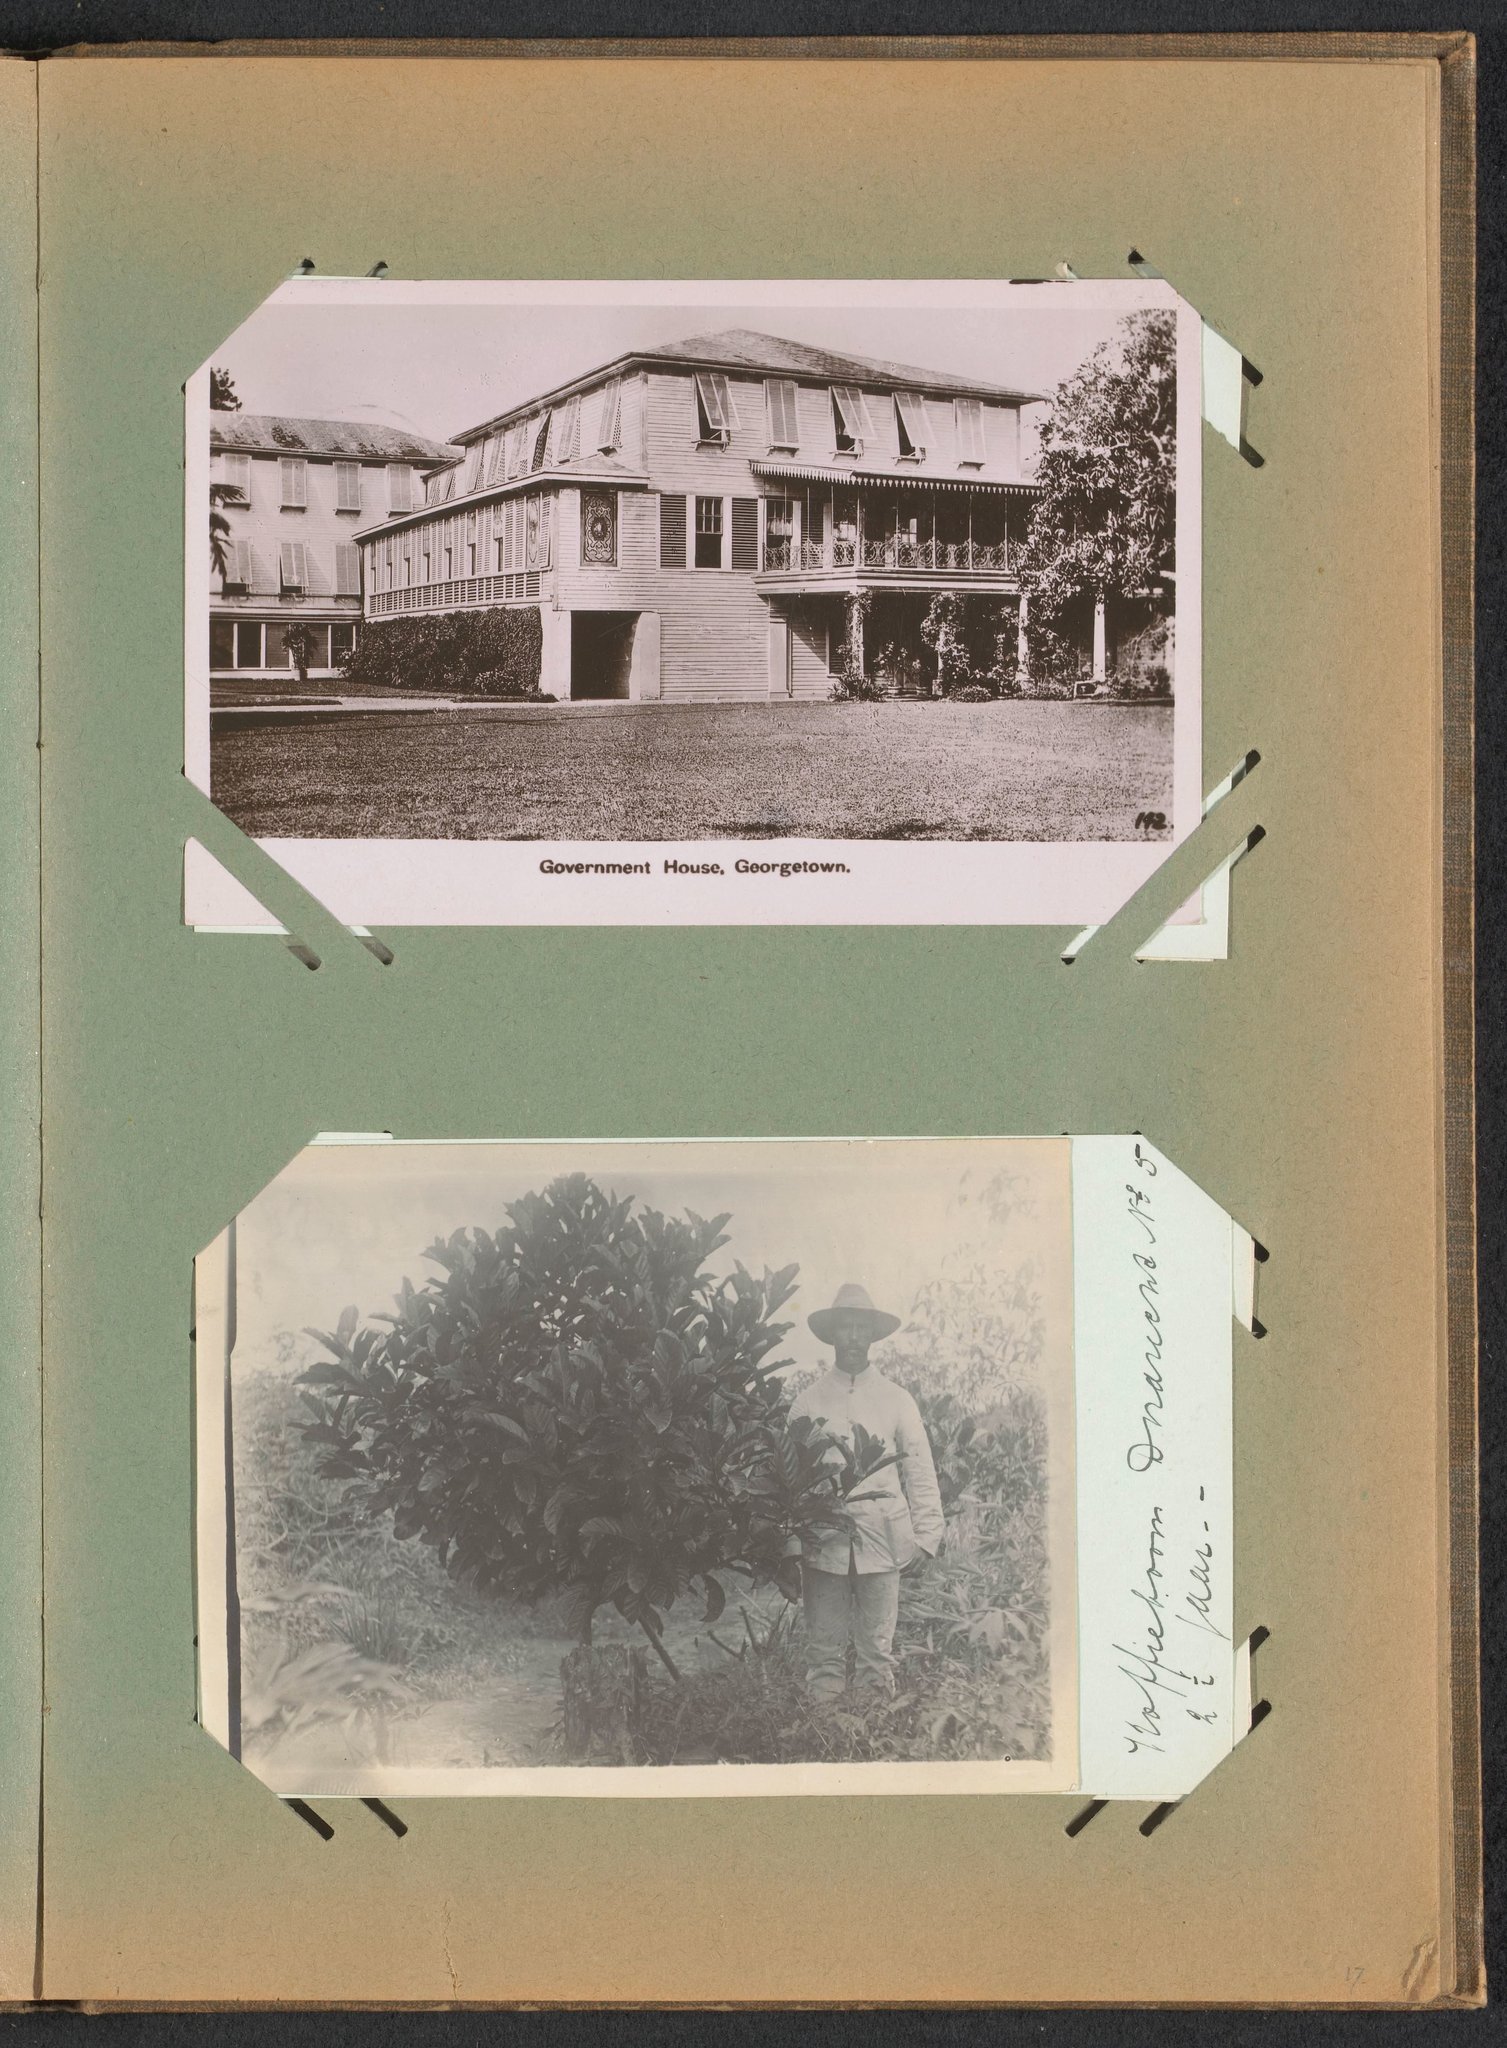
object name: photograph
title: Regeringsgebouw in Georgetown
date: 1910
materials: photographic support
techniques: gelatin silver print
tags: georgetown (colorado)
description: Regeringsgebouw in Georgetown, Guyana. Beschreven ansichtkaart verstuurd naar 'Surinaamsche Cultuur Mij.' in Den Haag. Onderdeel van het fotoalbum uit ca. 1912-1913 met 92 foto's van de plantages Peperpot en Dordrecht in Suriname en Mount Pleasant op Curaçao.